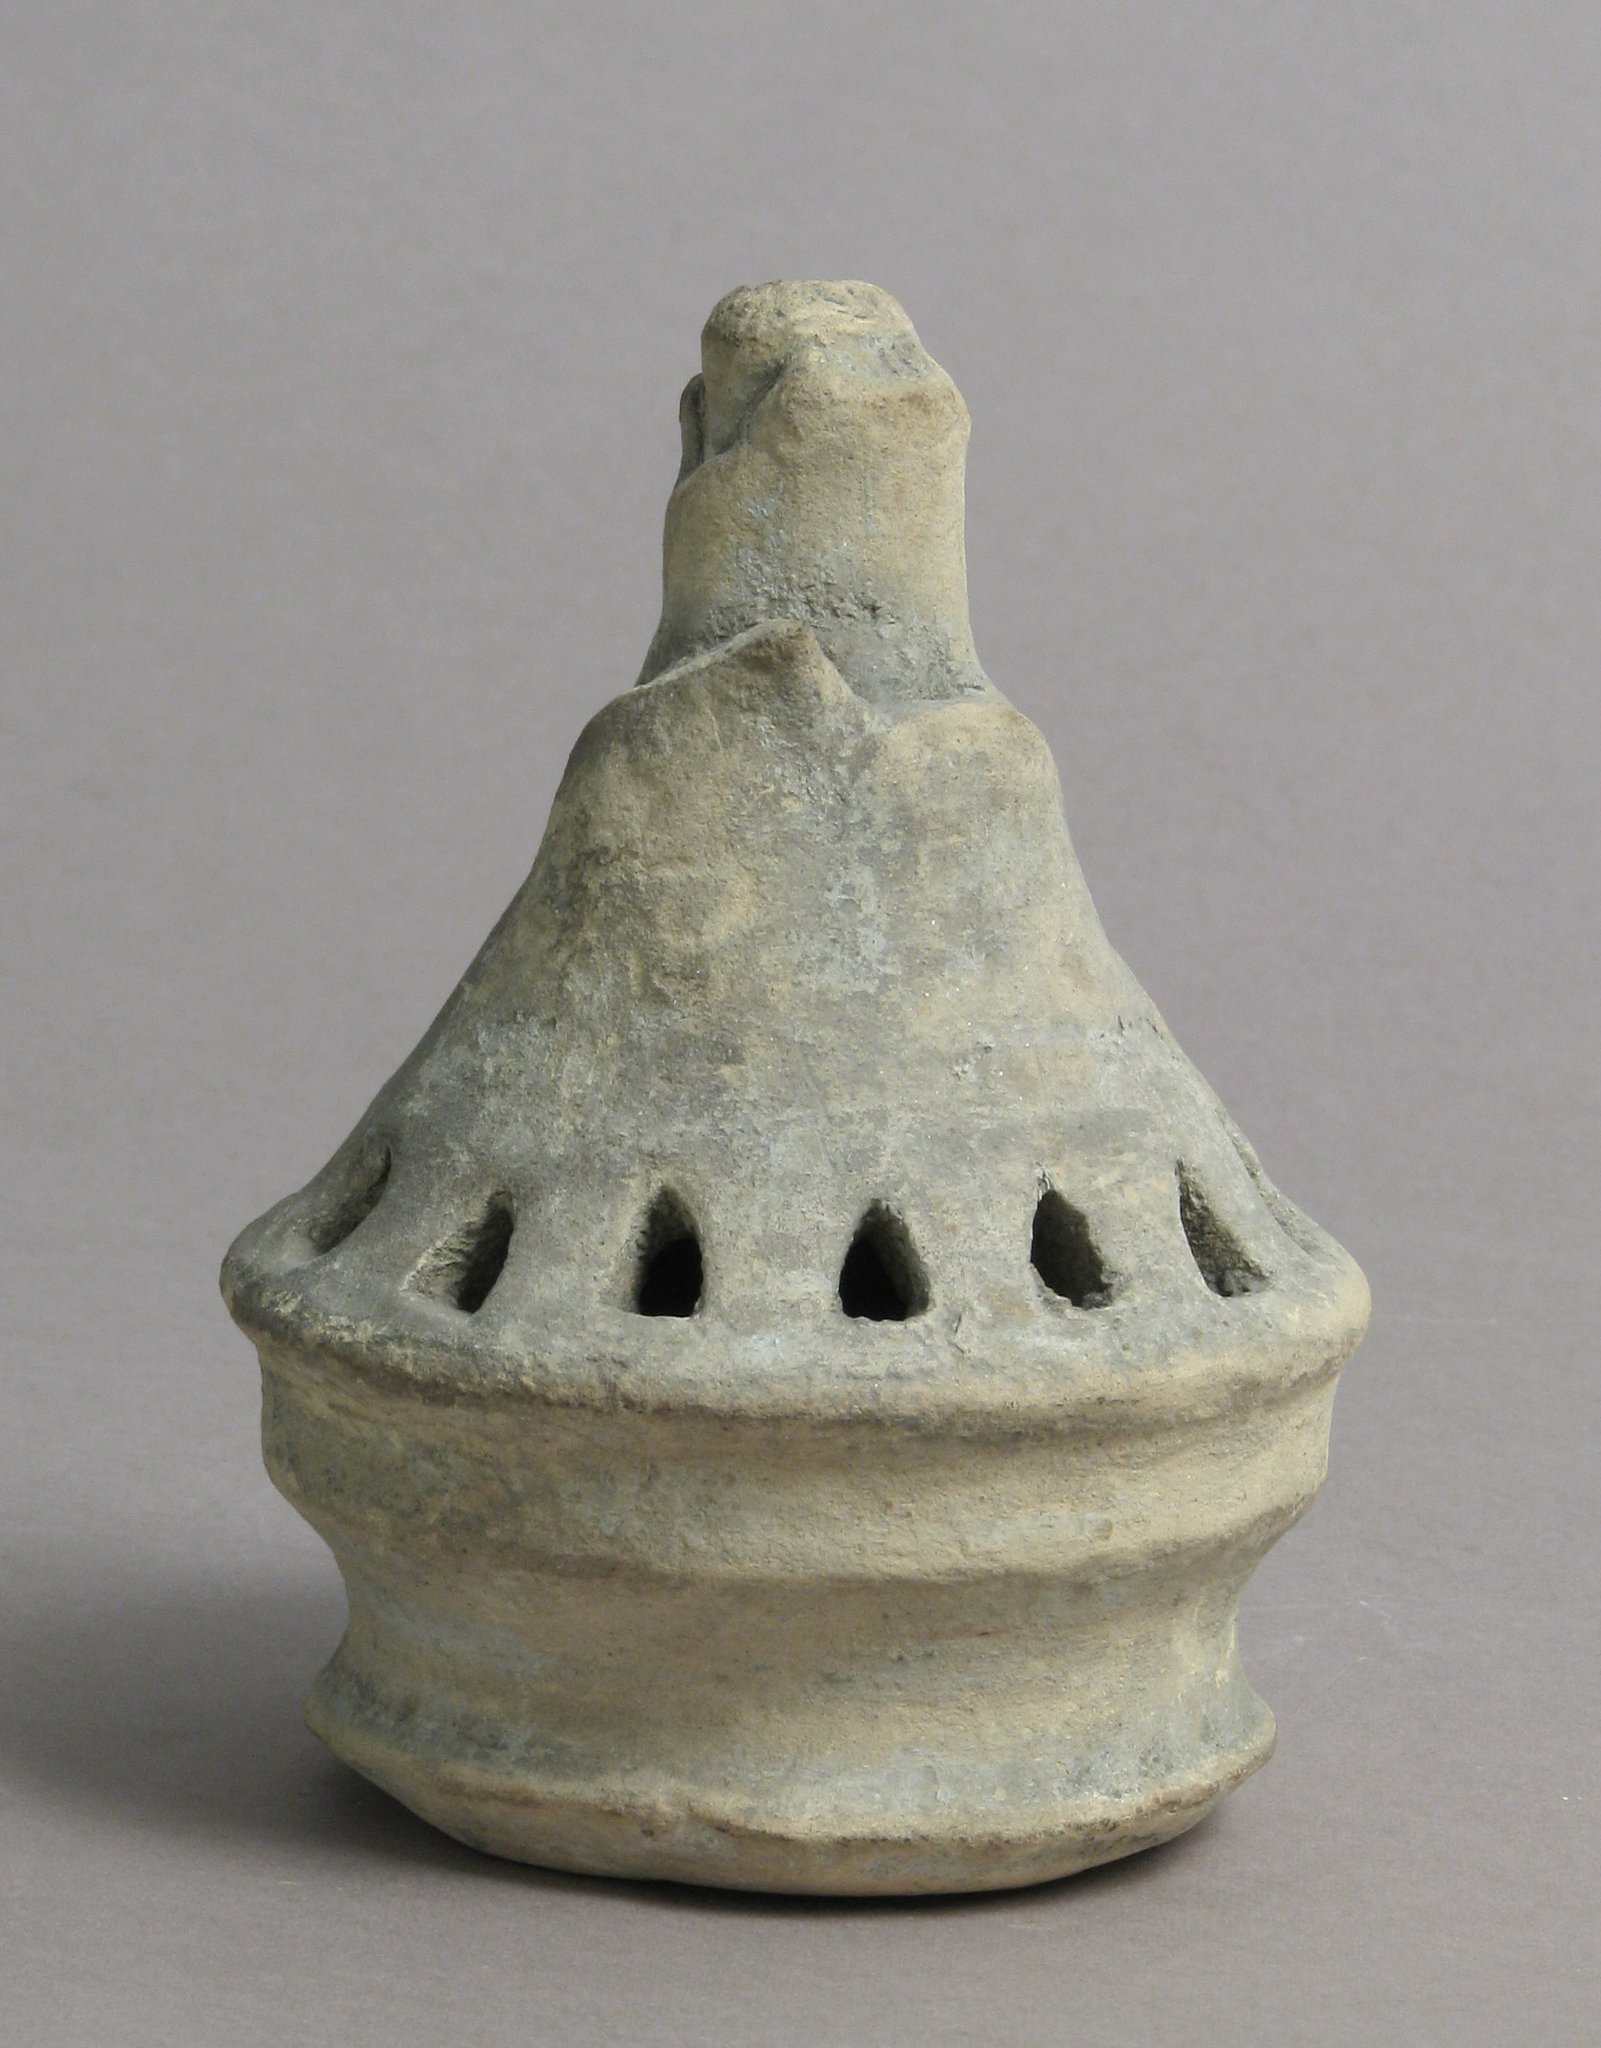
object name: ornament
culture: french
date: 1501-1600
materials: earthenware